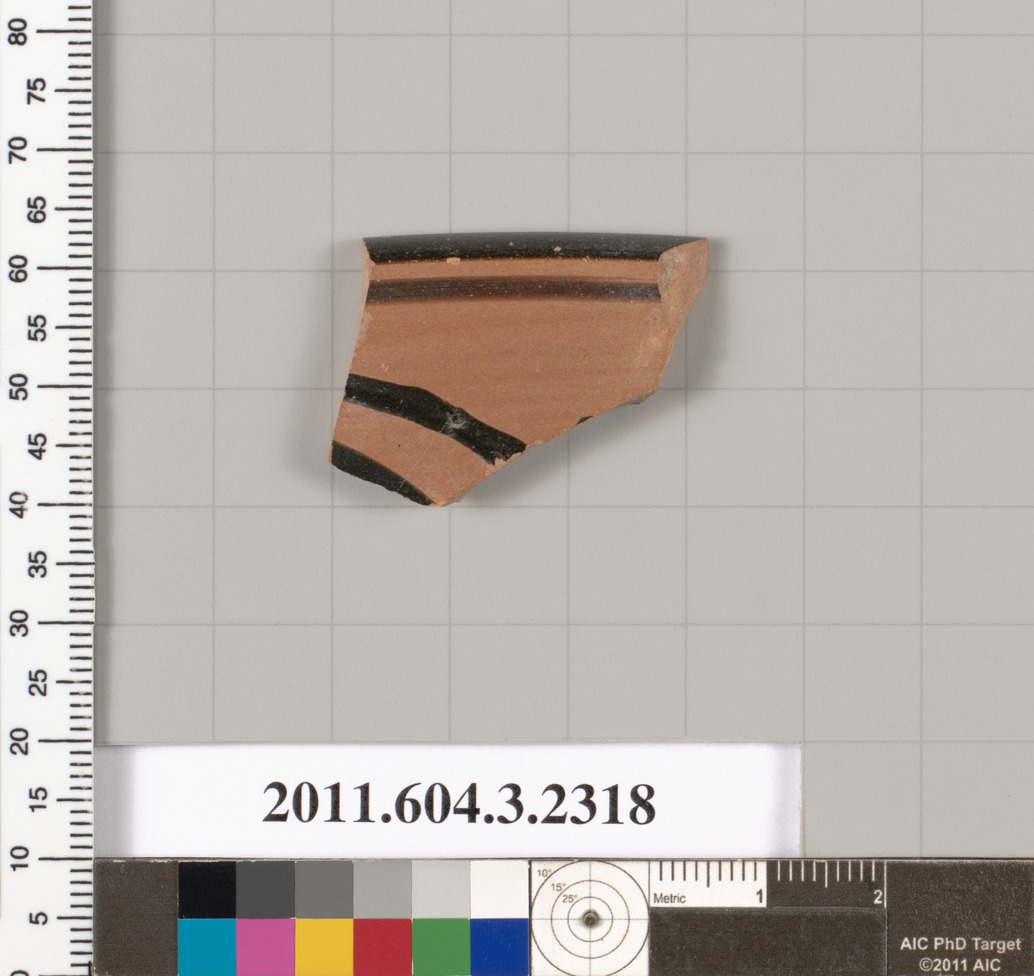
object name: kylix fragment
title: Terracotta rim fragment of a kylix: eye-cup (drinking cup)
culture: greek, attic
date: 530-500 BCE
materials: terracotta